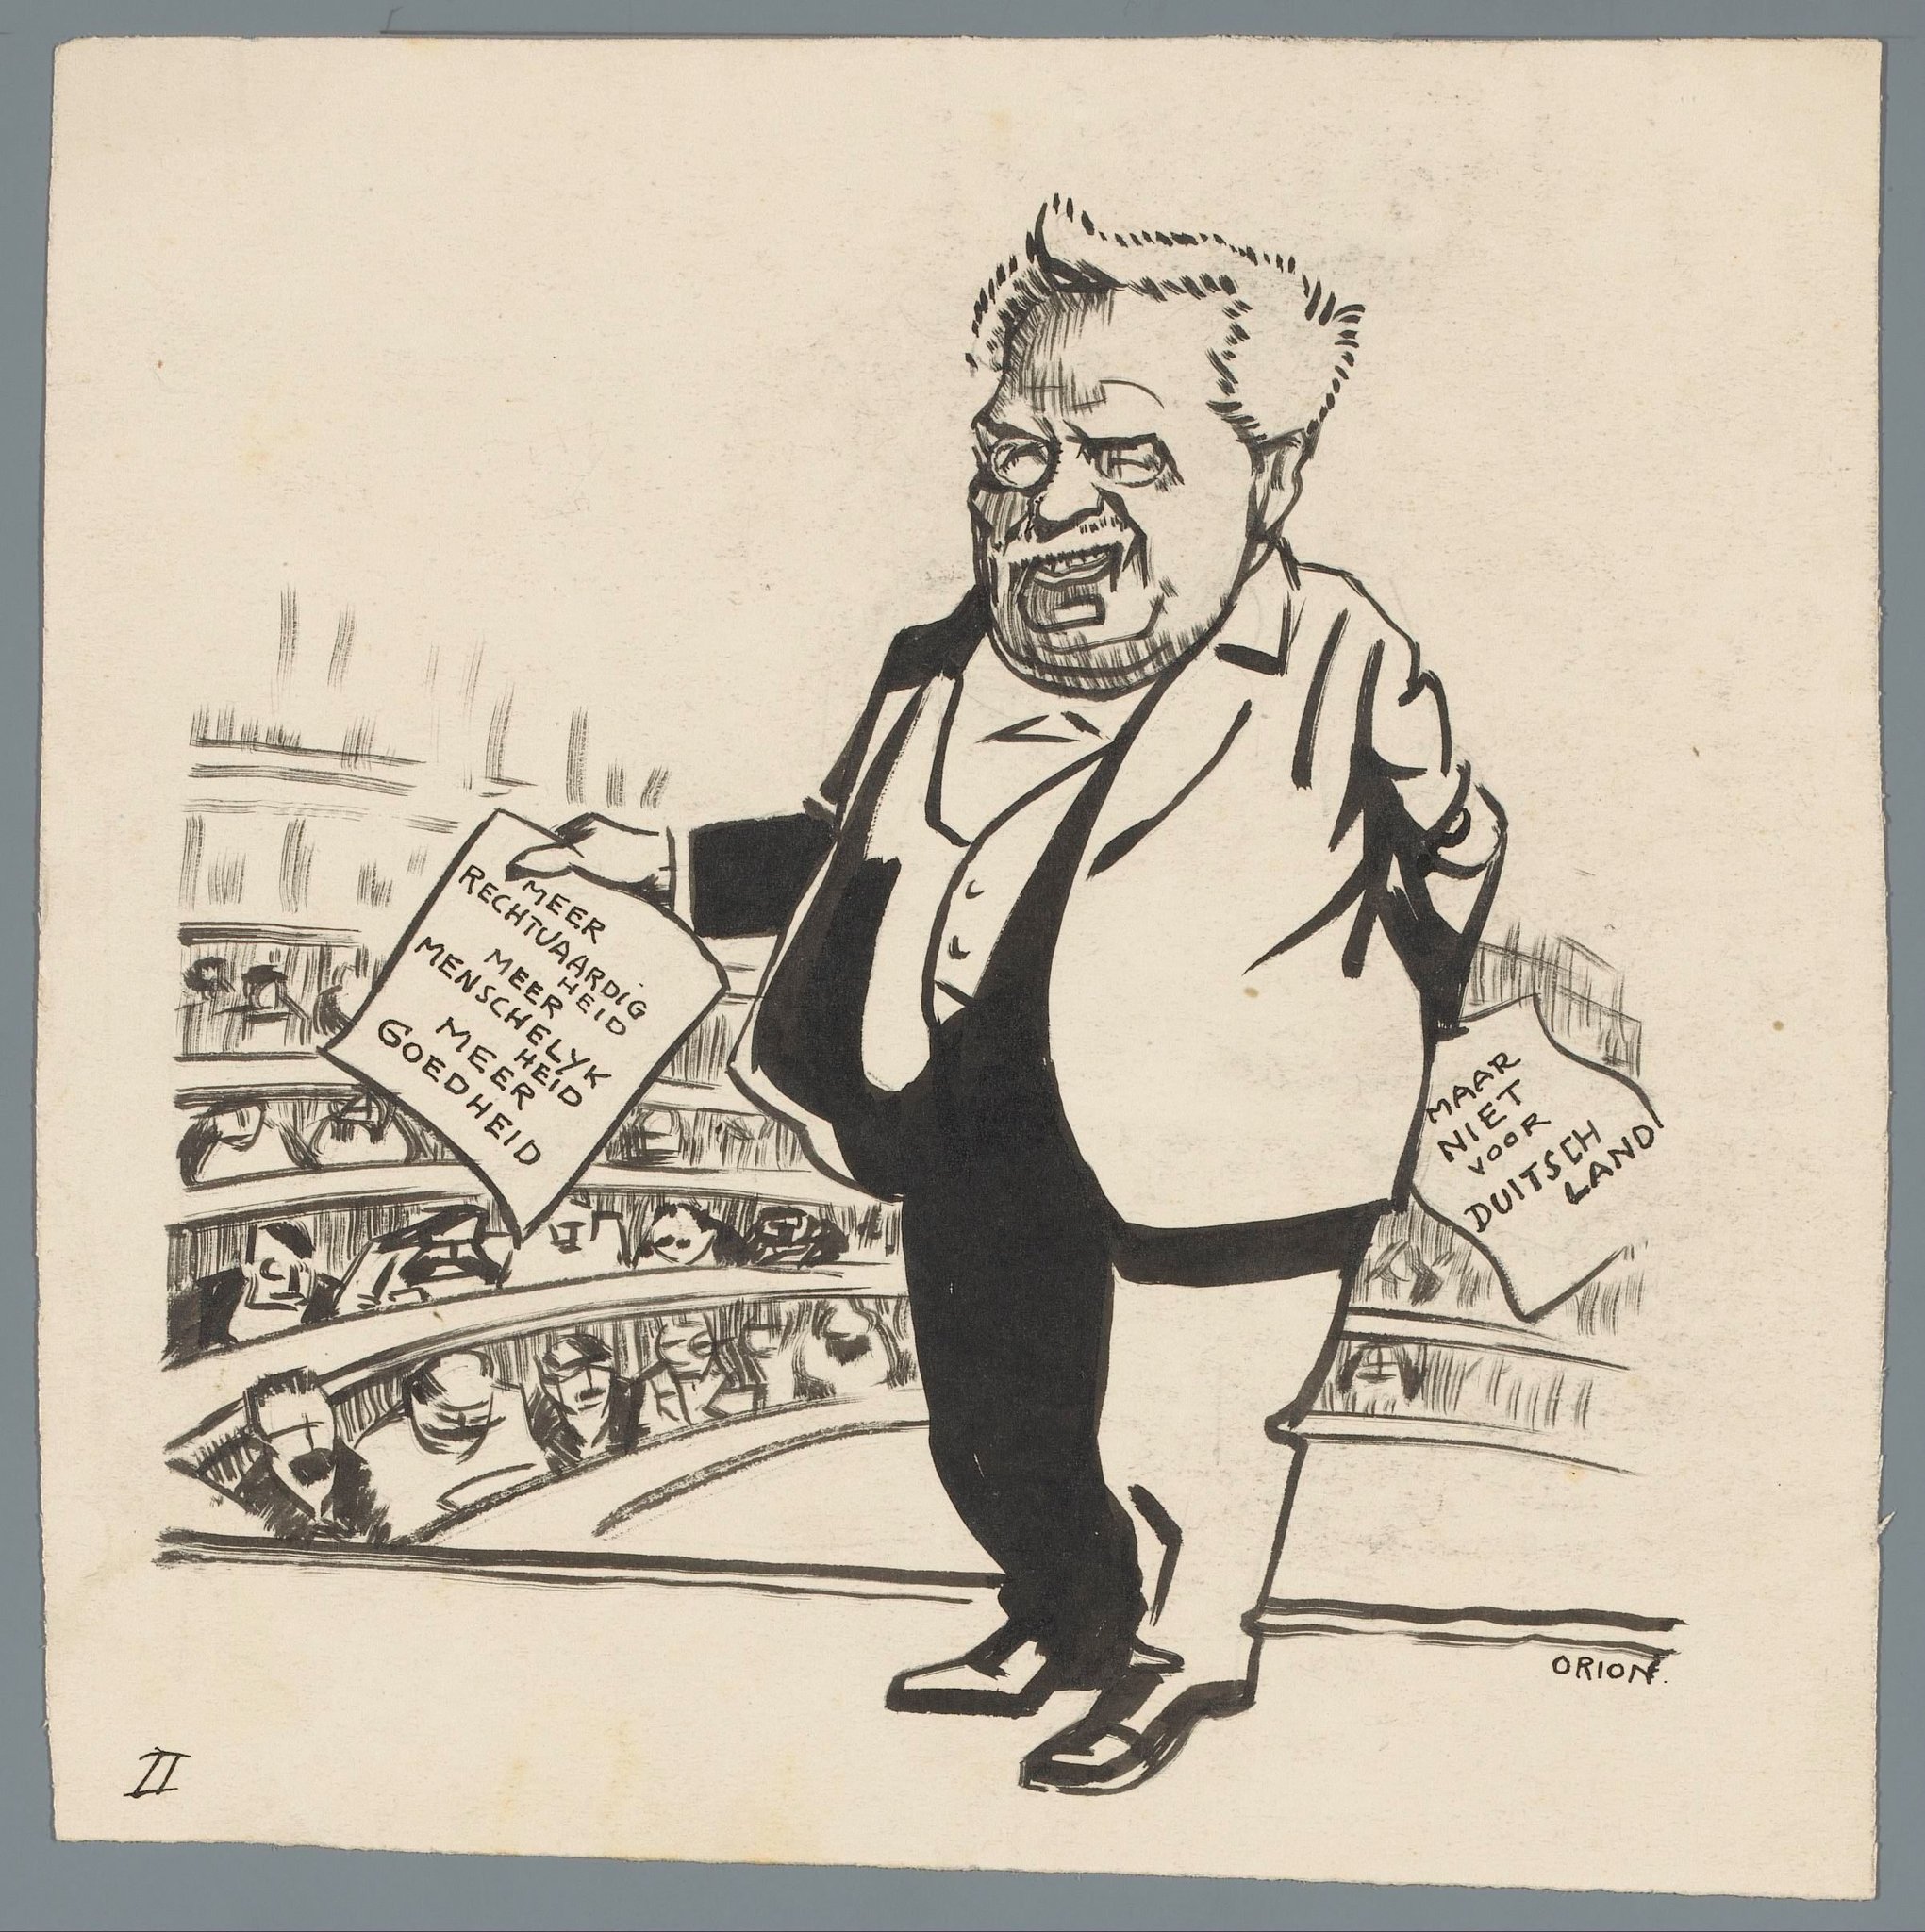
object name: drawing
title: Meer rechtvaardigheid meer menschelykheid meer goedheid / maar niet voor Duitschland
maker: patricq kroon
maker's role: draughtsman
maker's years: 1862-1941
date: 1918-1935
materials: ink, paper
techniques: brush, pen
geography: netherlands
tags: political caricatures and satires, germany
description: Een staatsman op het toneel met twee documenten in de hand. Waarschijnlijk naar aanleiding van de strenge behandeling van Duitsland in de jaren '20. Ontwerp voor een politieke spotprent.